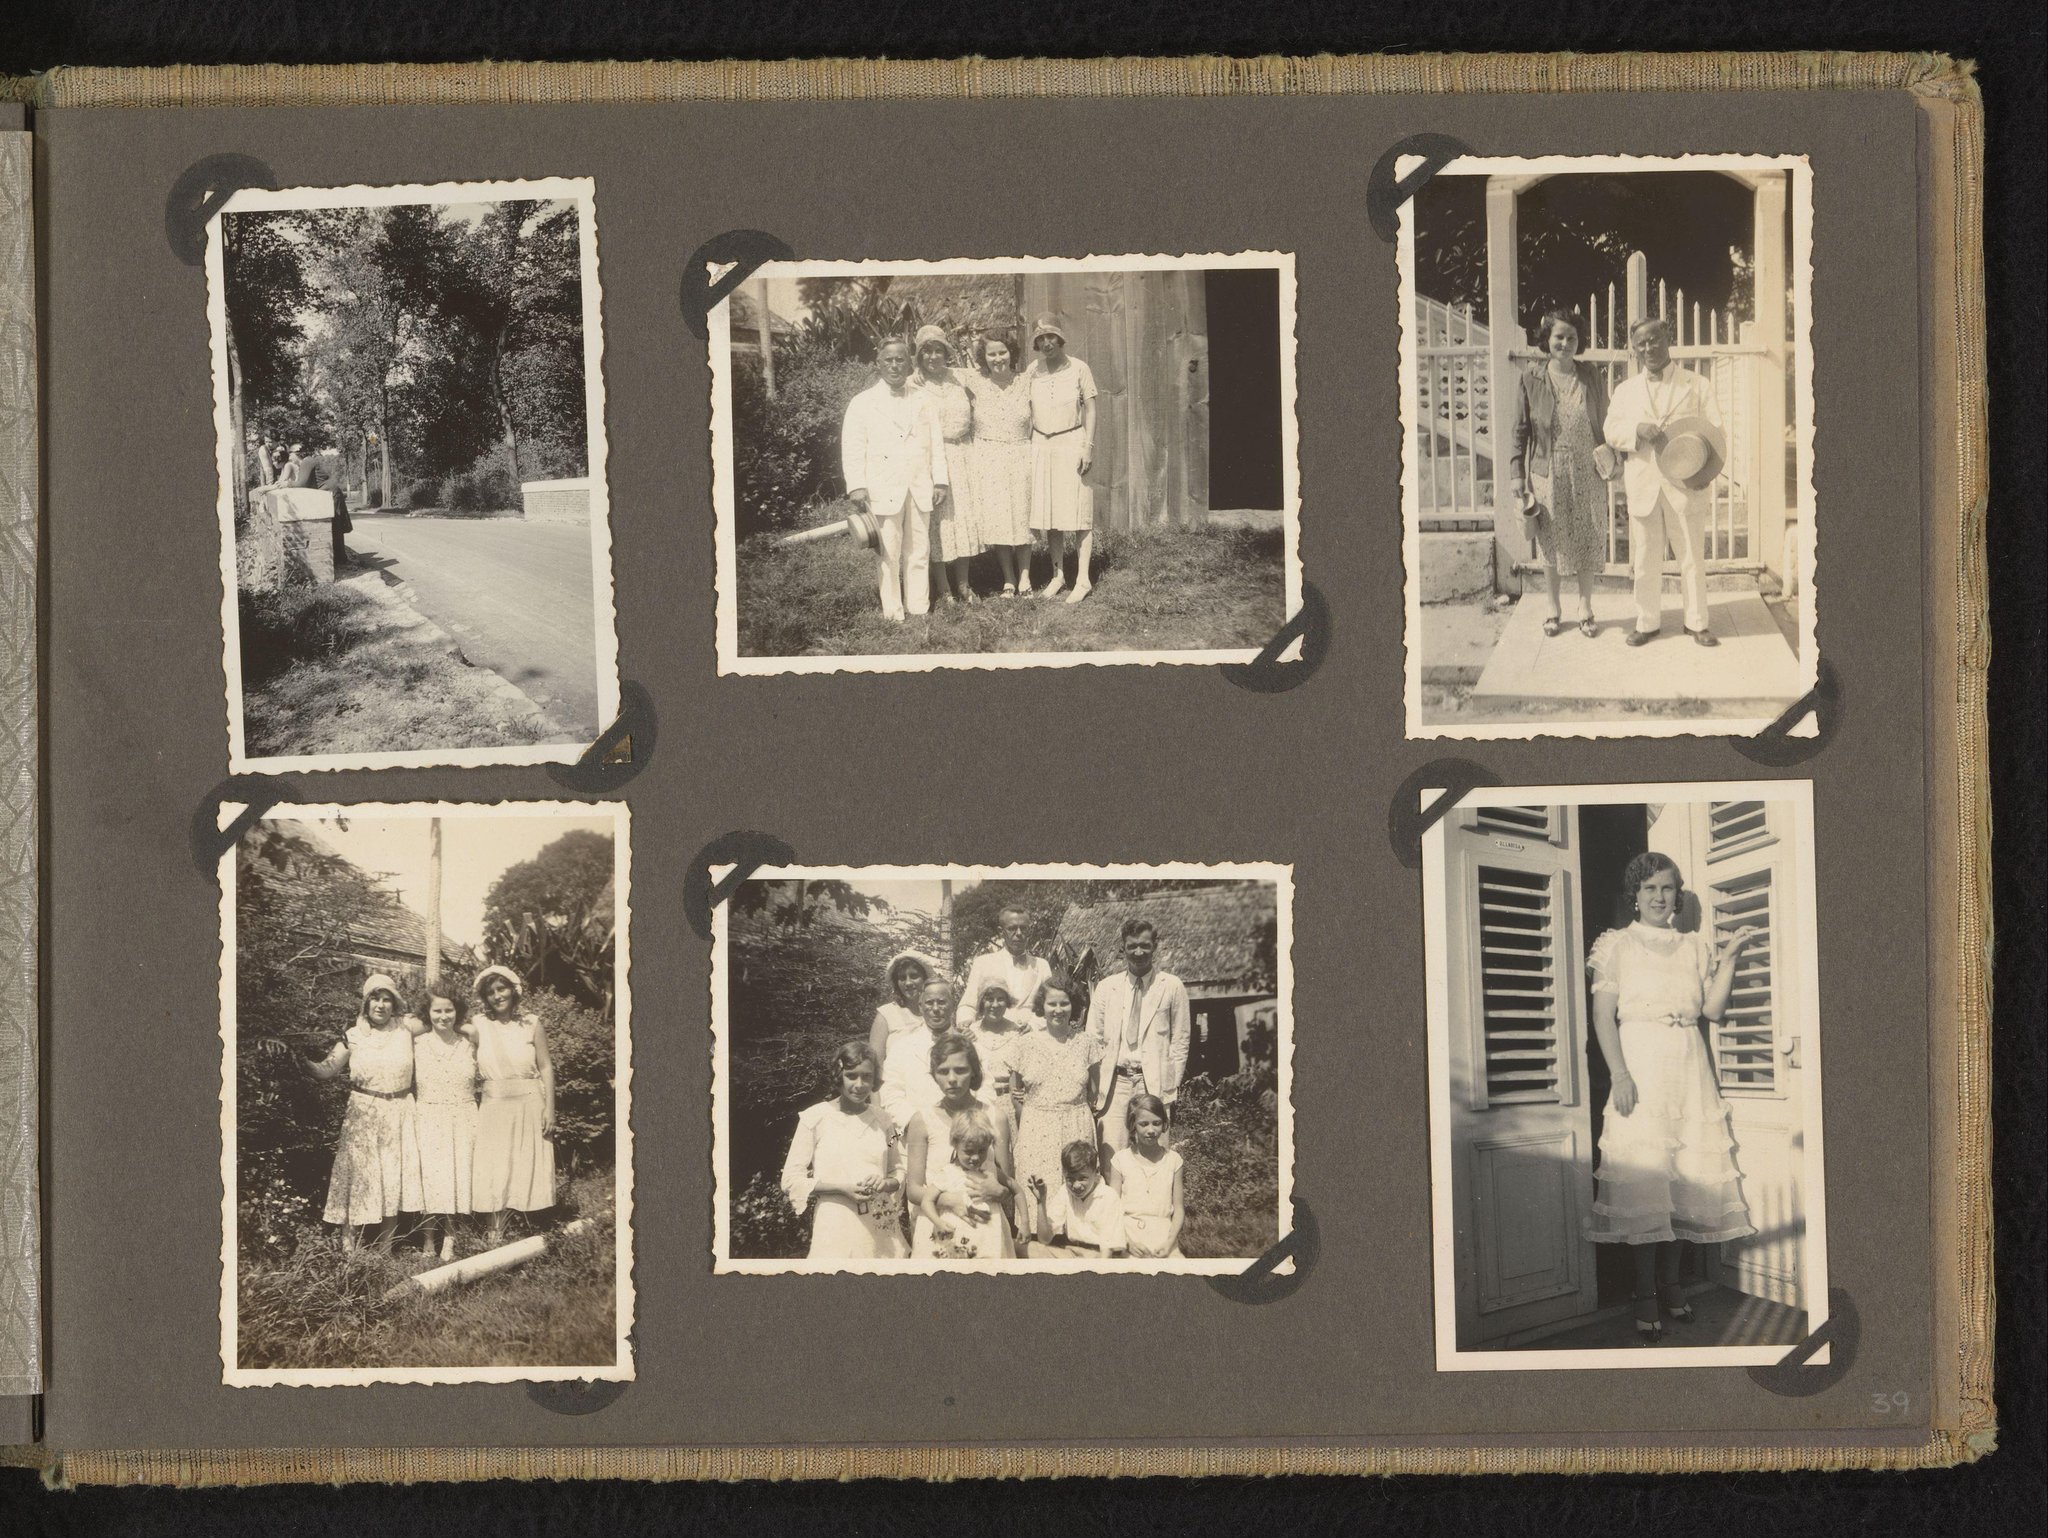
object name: album leaf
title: Vrienden of familie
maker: Anonymous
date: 1930-1931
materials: cardboard, photographic support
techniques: gelatin silver print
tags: family, descendance, friends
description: Albumblad met zes foto's van vrienden of familie, allen in witte kleding. Onderdeel van fotoalbum 'Studentenalbum Indologen'.